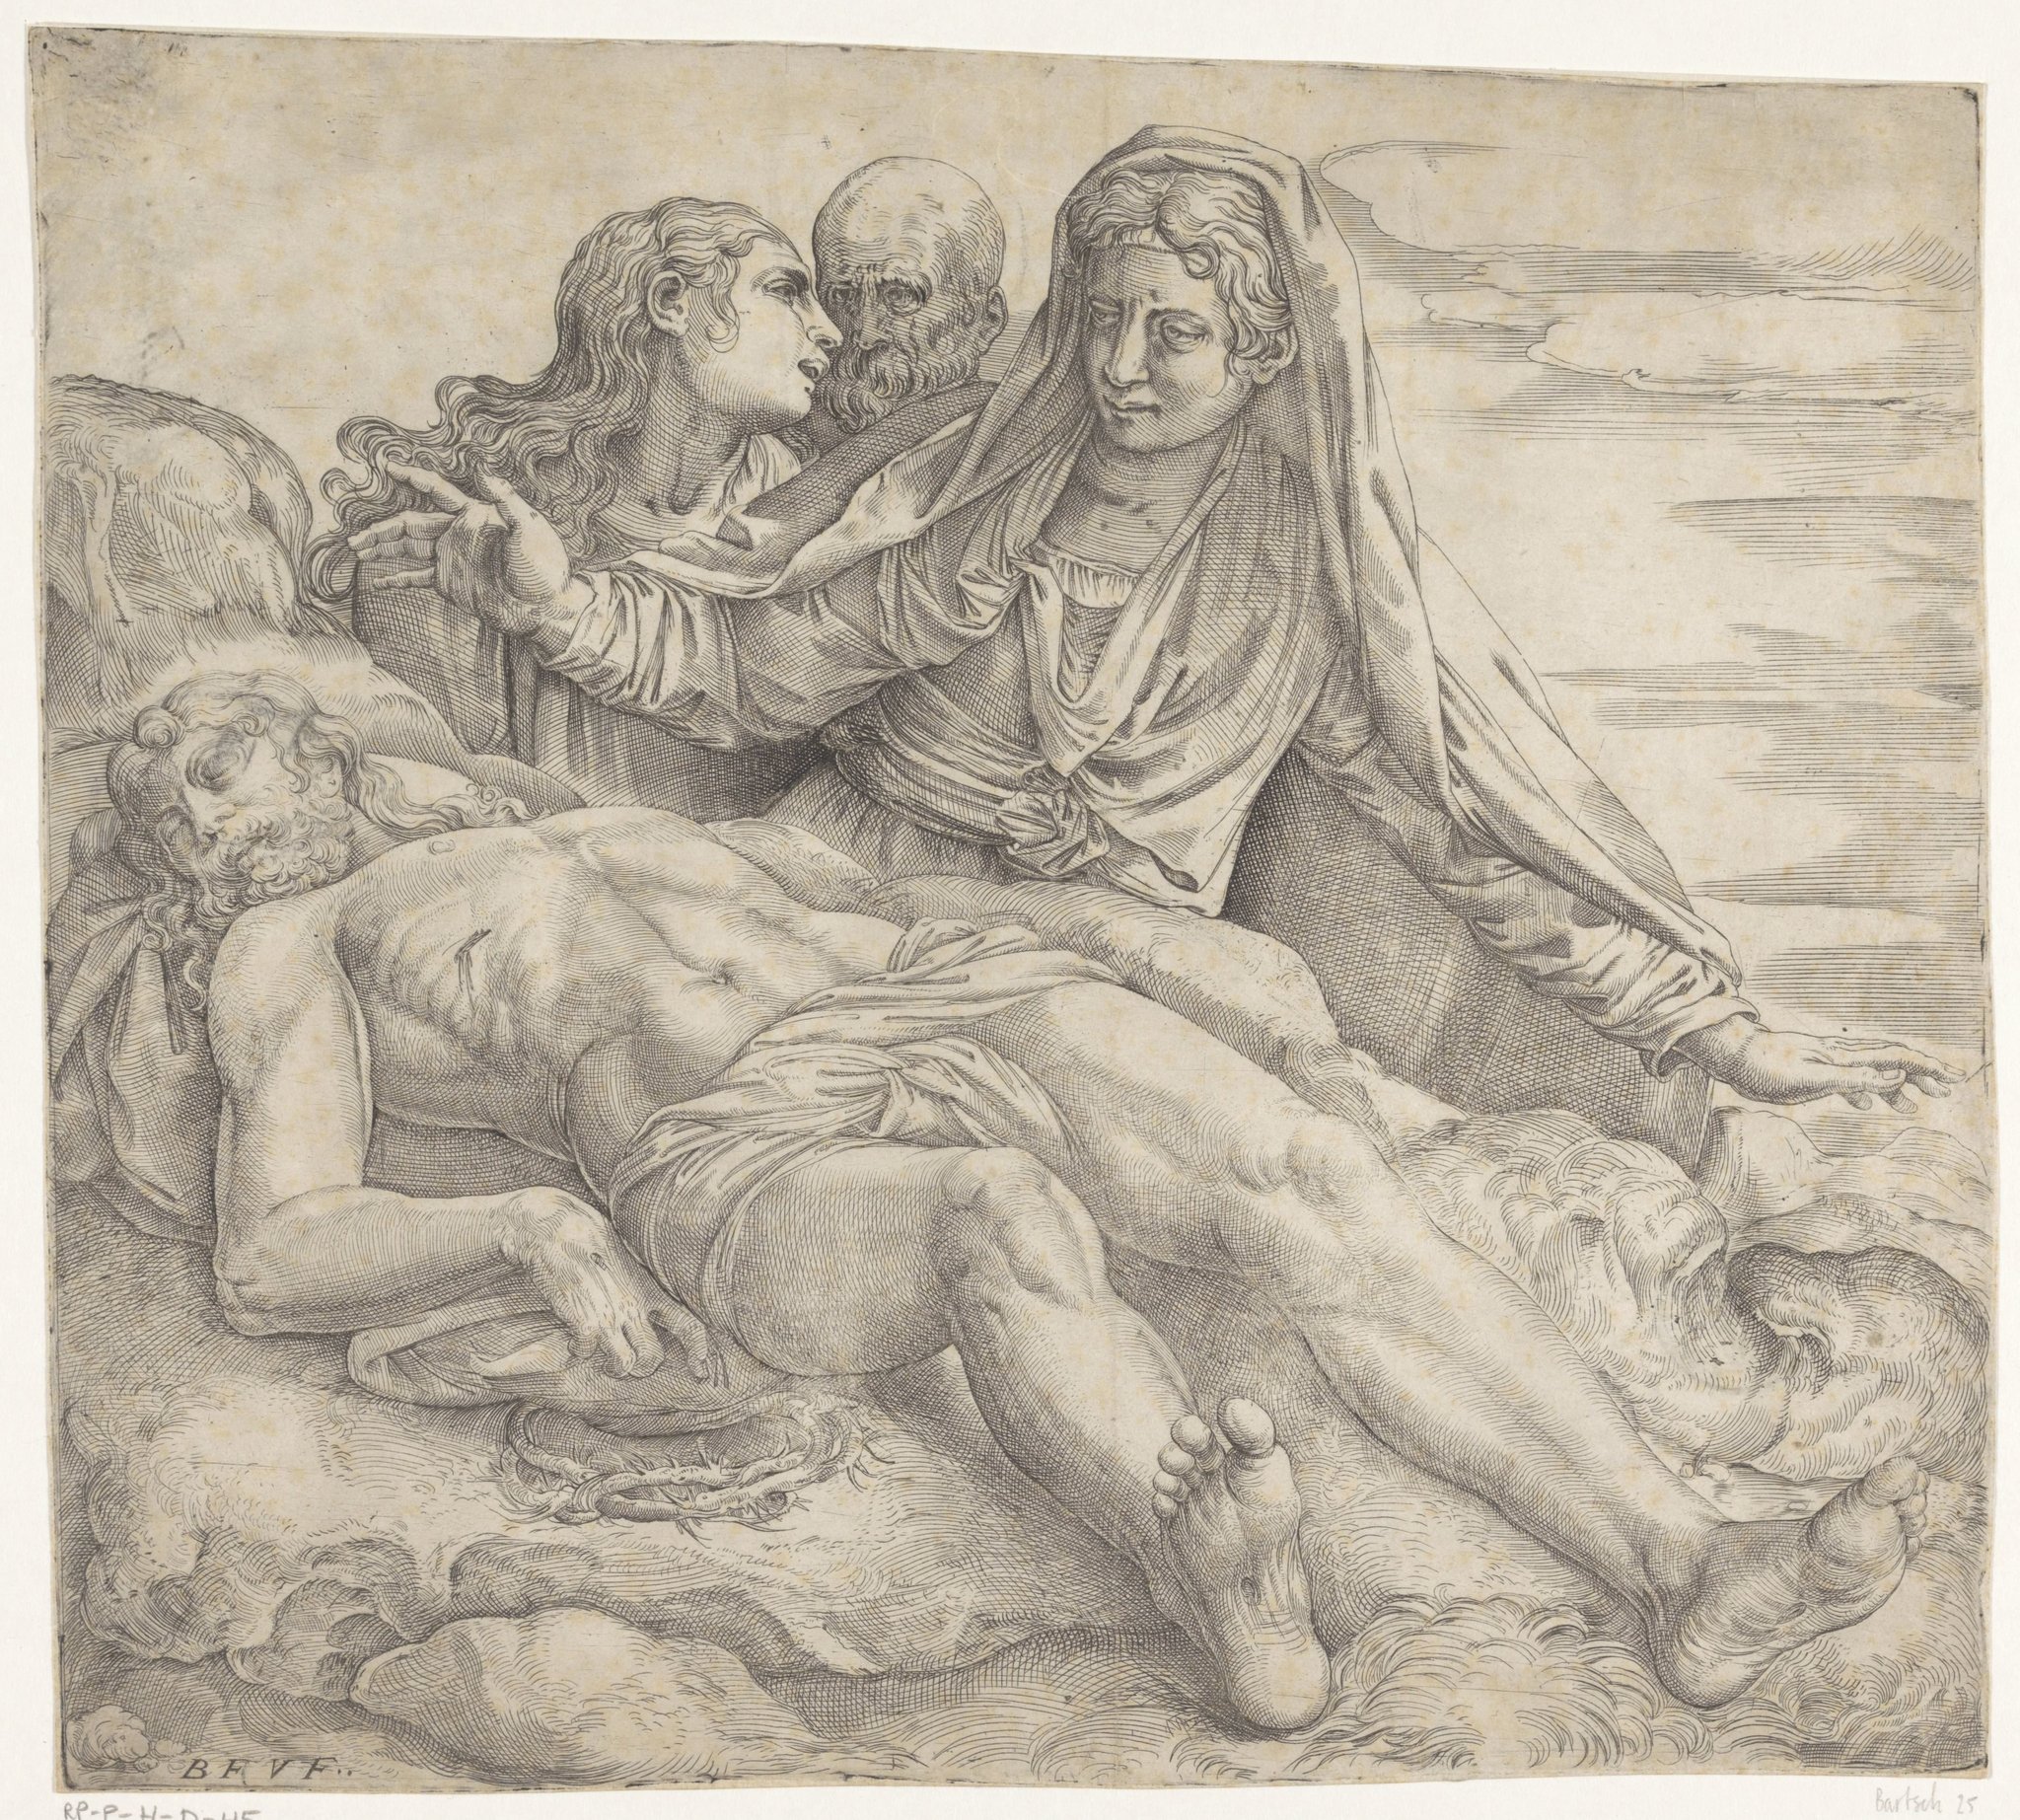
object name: print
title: De Bewening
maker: battista franco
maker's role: draughtsman, painter, print maker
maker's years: 1510-1561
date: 1520-1561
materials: paper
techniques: engraving, etching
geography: italy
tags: lamentation over the dead christ by his relatives and friends (christ usually without crown of thorns)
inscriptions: collector's mark: Lugt 11, collector's mark: Lugt 10, collector's mark: ‘Hinloopen’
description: Maria en twee andere figuren treuren bij het lichaam van Christus.